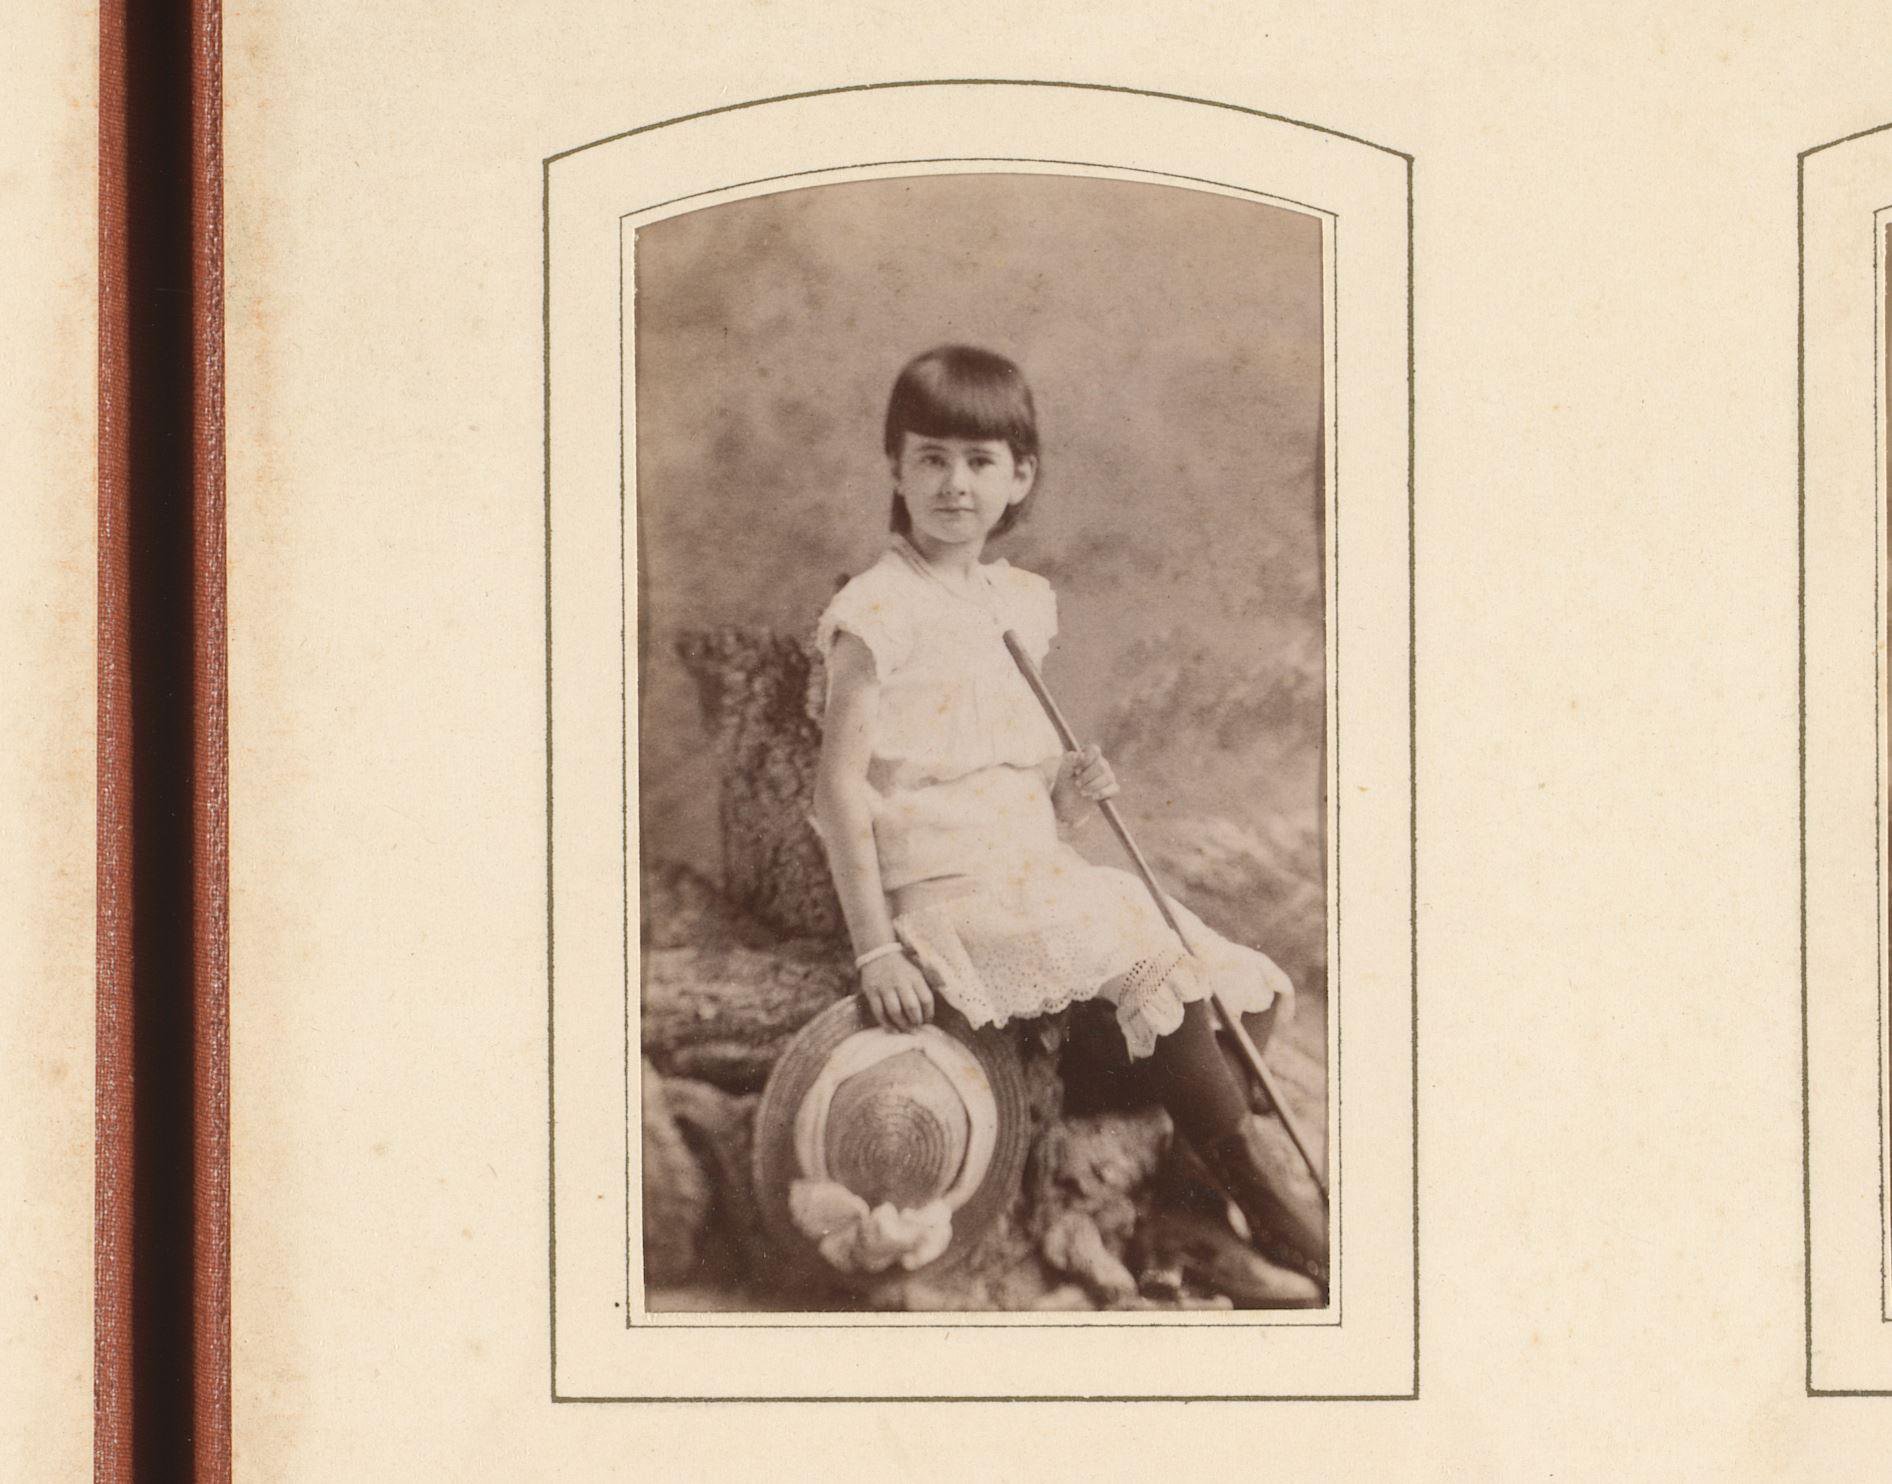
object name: album leaf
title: Portret van een zittend meisje met stok en hoed in de hand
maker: Anonymous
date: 1860-1900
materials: cardboard, photographic support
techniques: albumen print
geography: netherlands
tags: sitting figure - aa - female human figure, historical persons - bb - woman, girl (child between toddler and youth), head-gear: hat